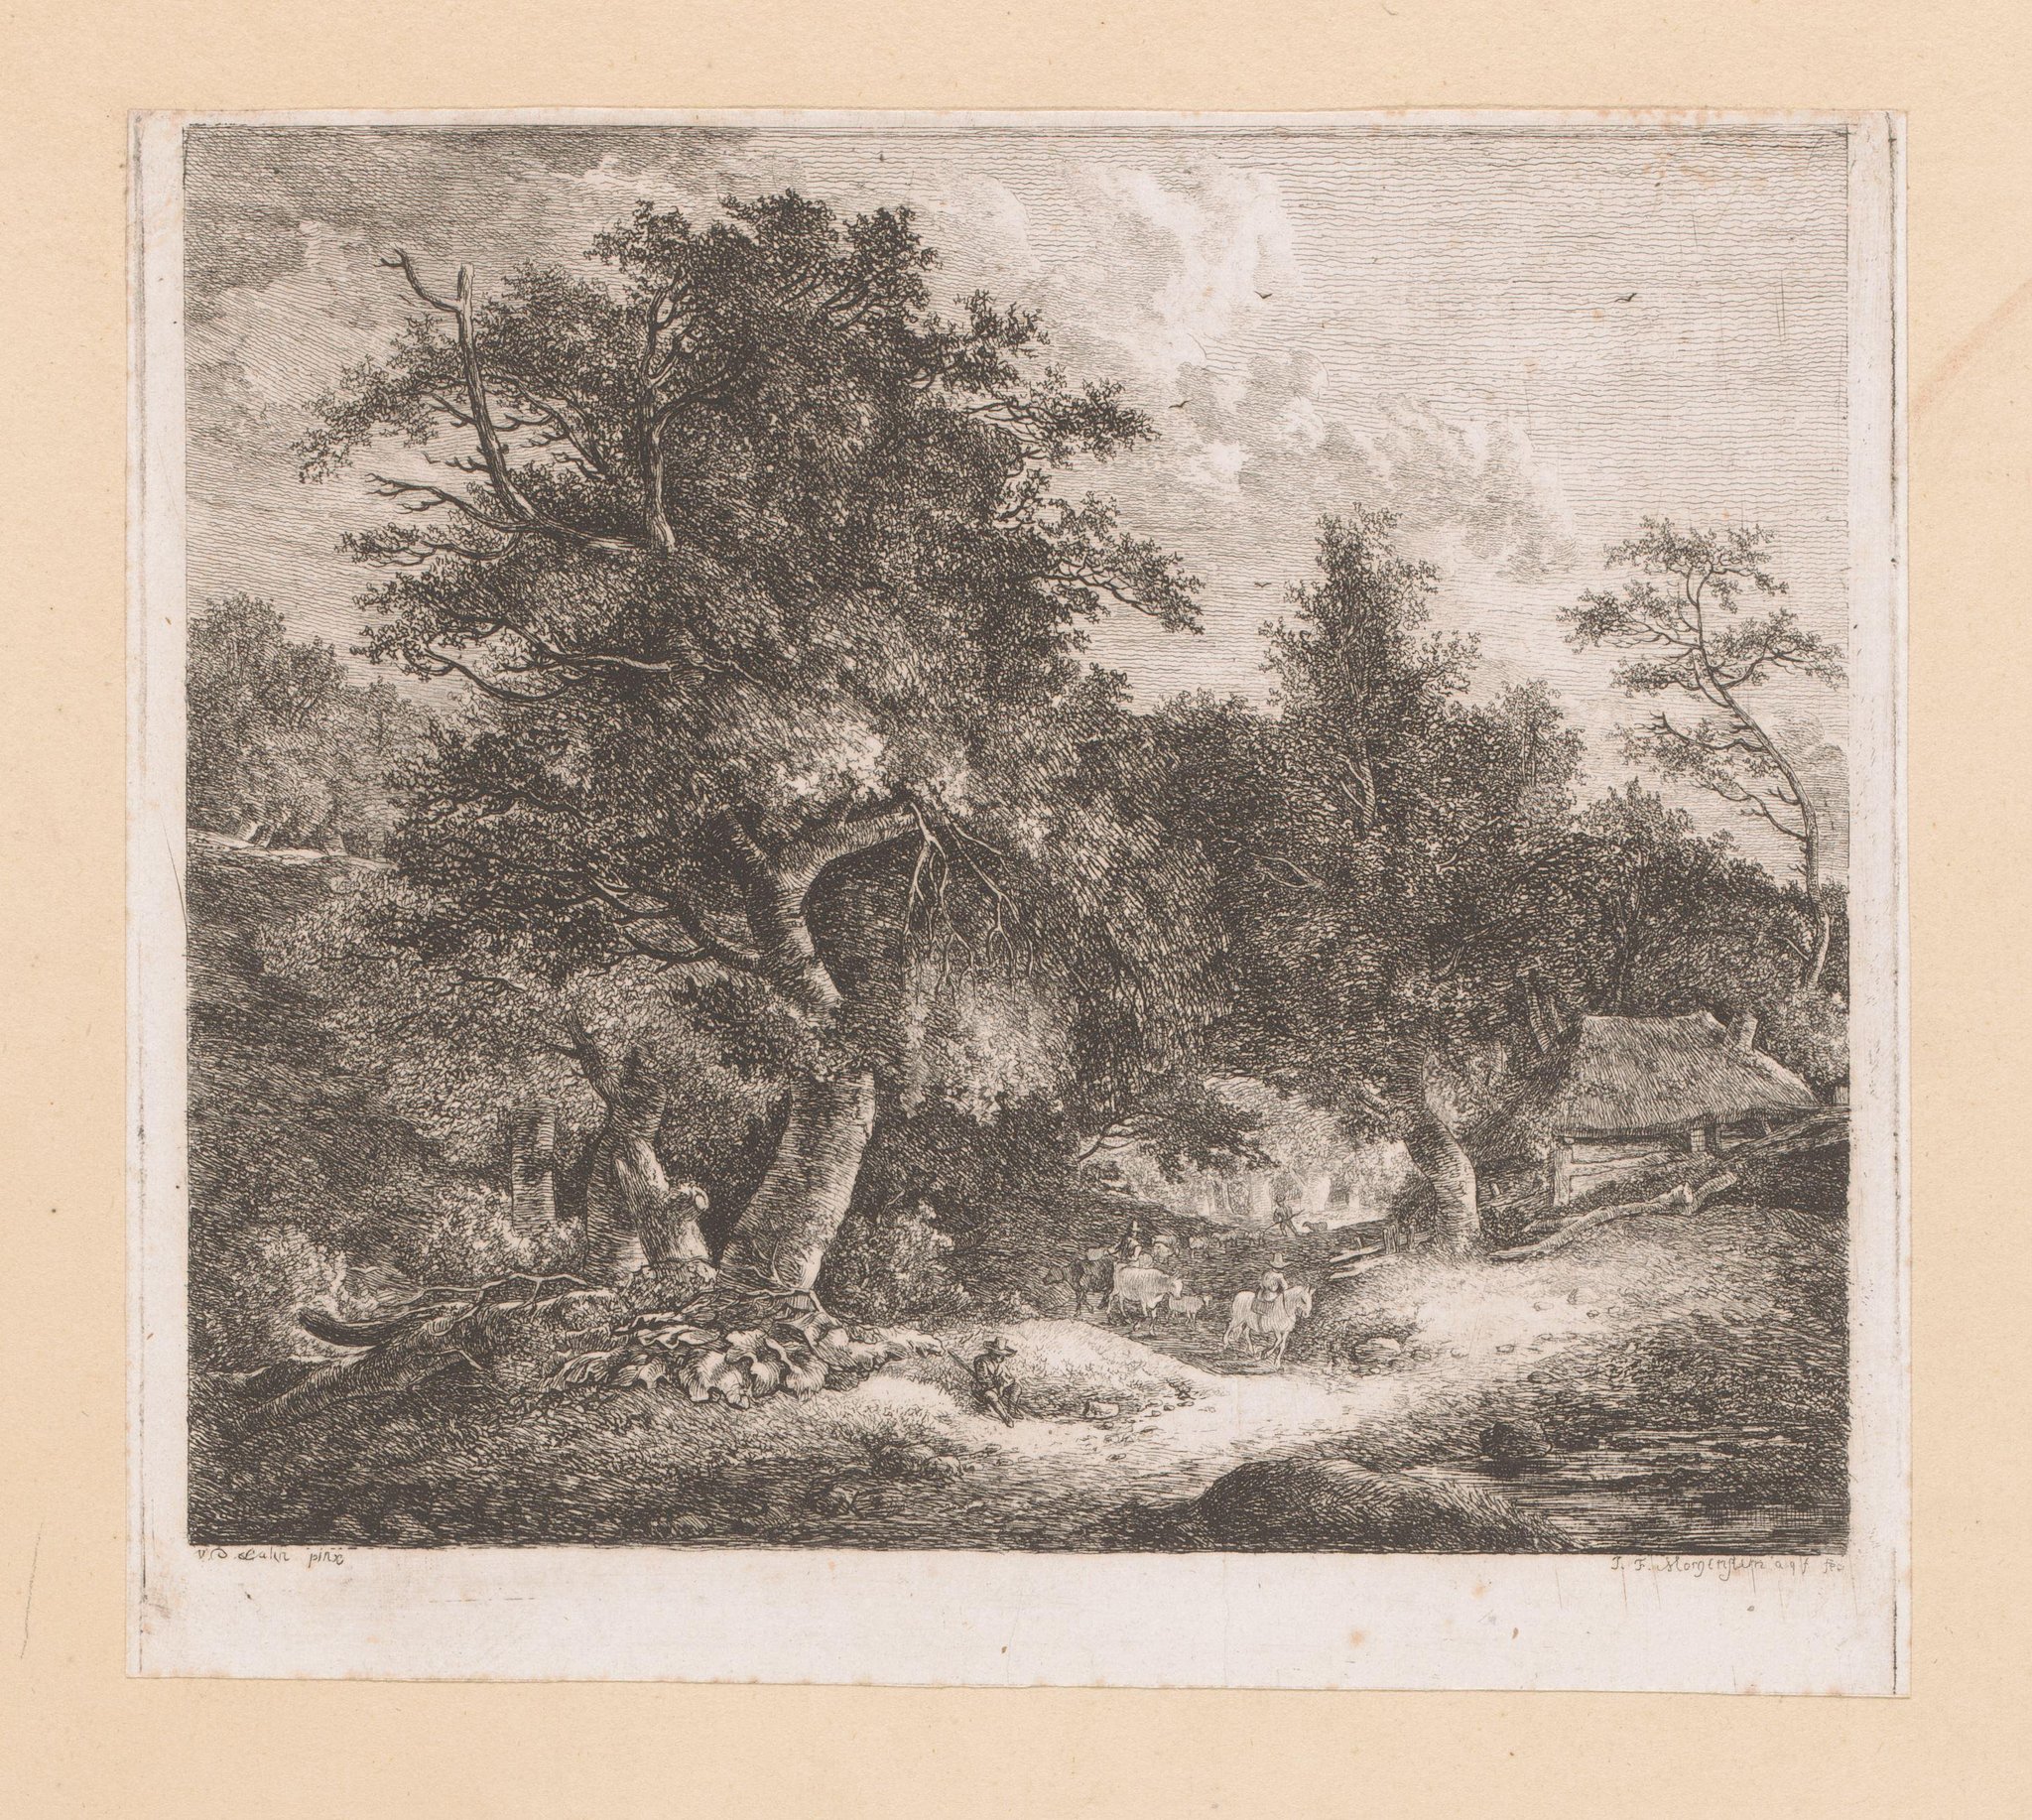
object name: print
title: Boslandschap met ruiters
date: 1787-1844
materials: paper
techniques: etching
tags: landscapes, 'en route', traveller under way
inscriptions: collector's mark: Lugt 2228